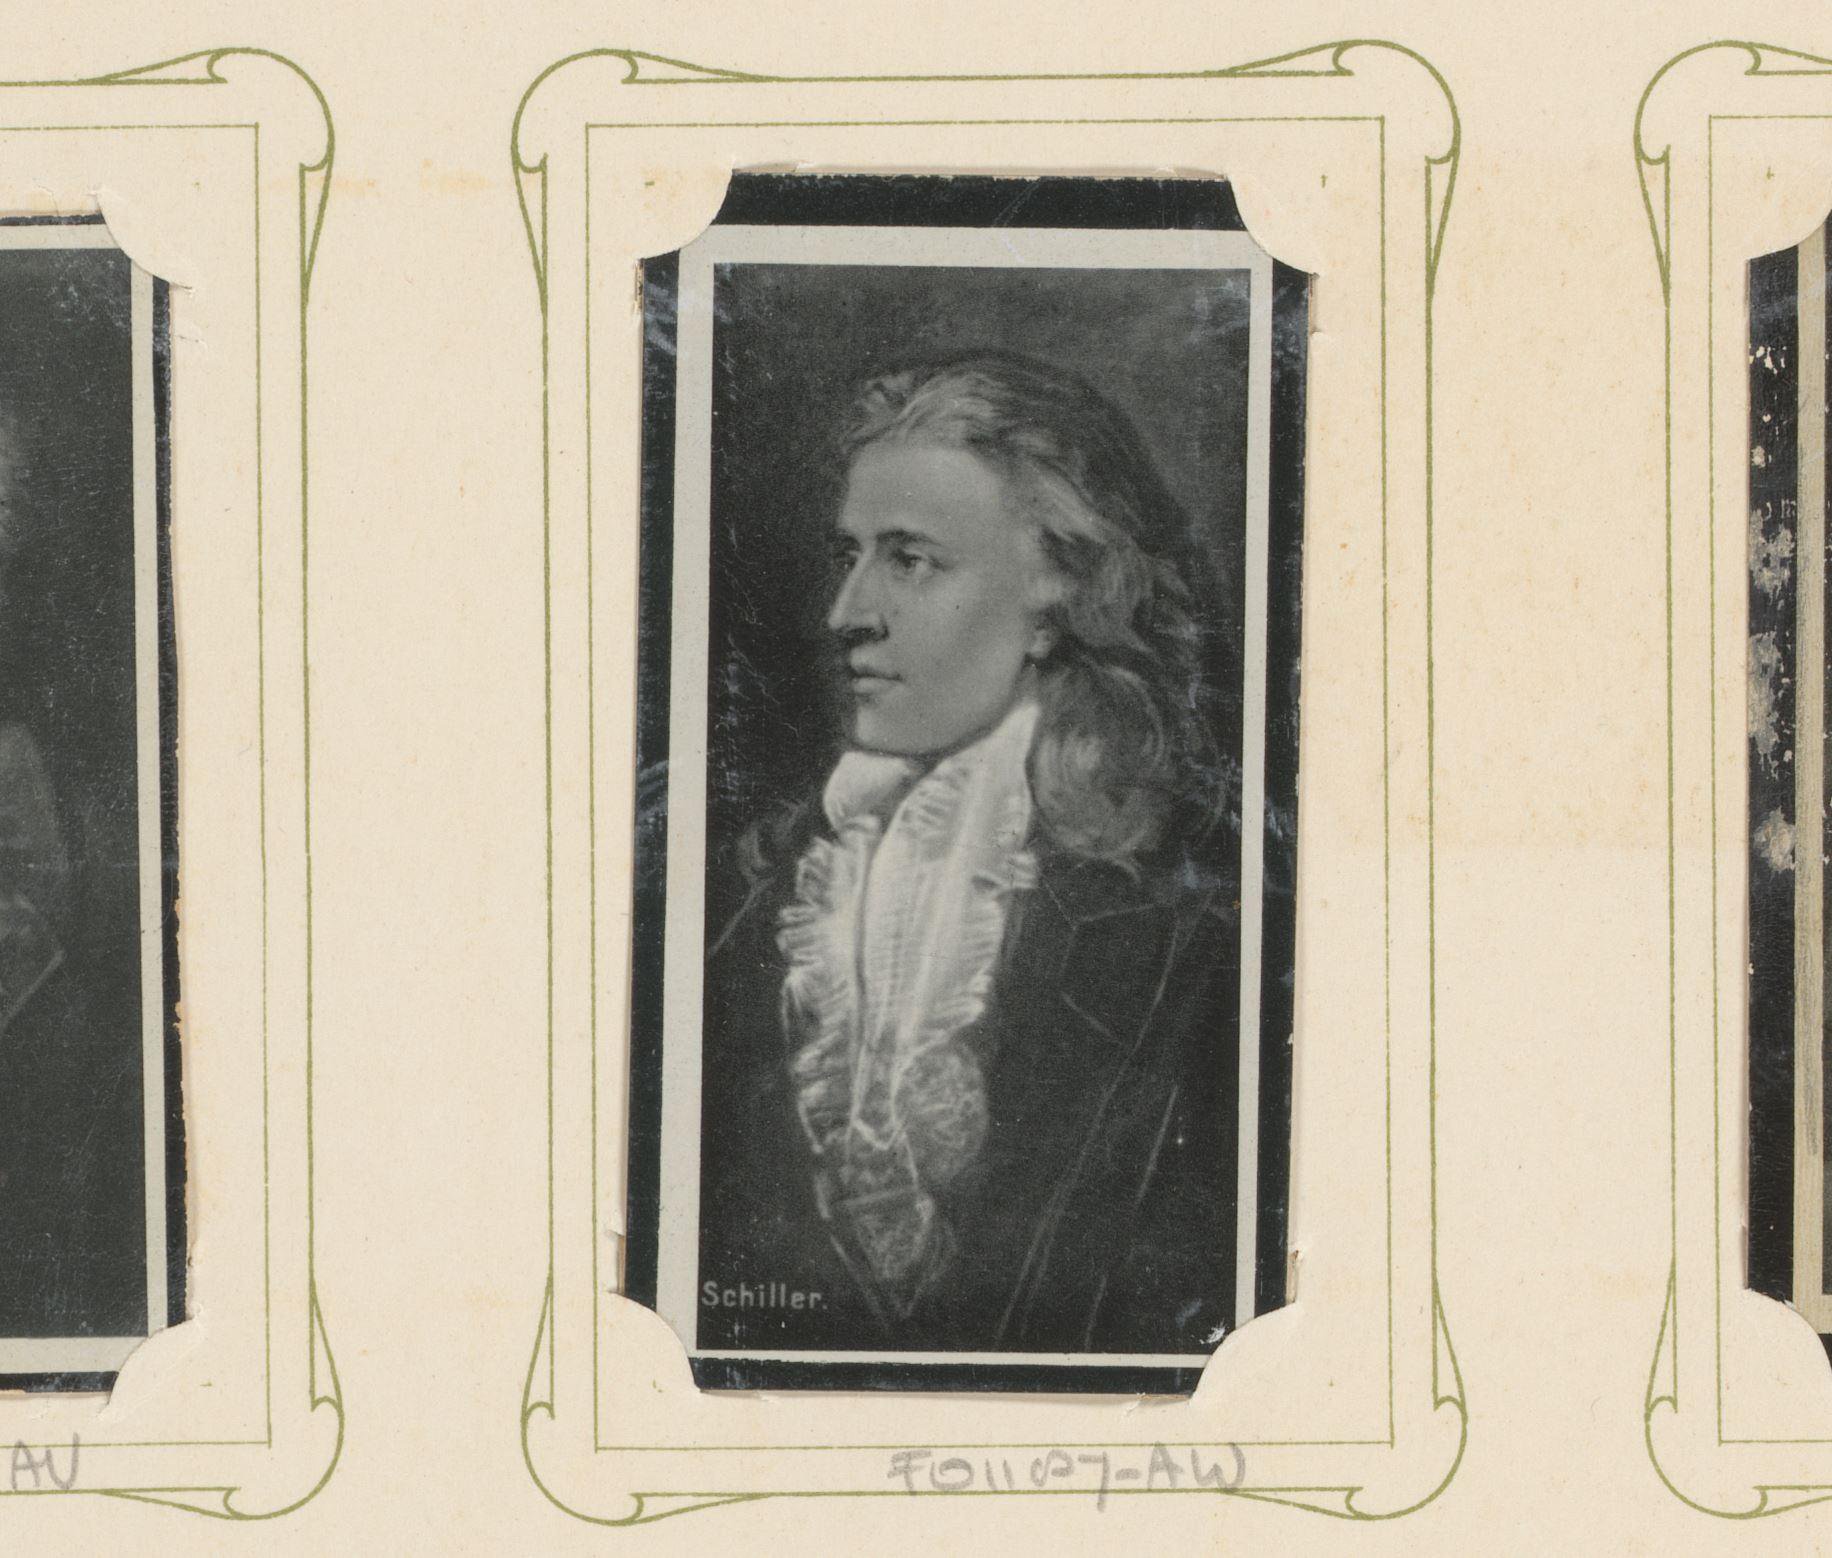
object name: photomechanical print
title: Reproductie van een geschilderd portret van Friedrich von Schiller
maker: Anonymous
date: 1905-1906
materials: paper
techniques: photograph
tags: friedrich von schiller, historical persons, portrait of a writer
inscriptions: inscription: ‘No. 2./ Schiller.’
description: Deze prent maakt deel uit van een album.